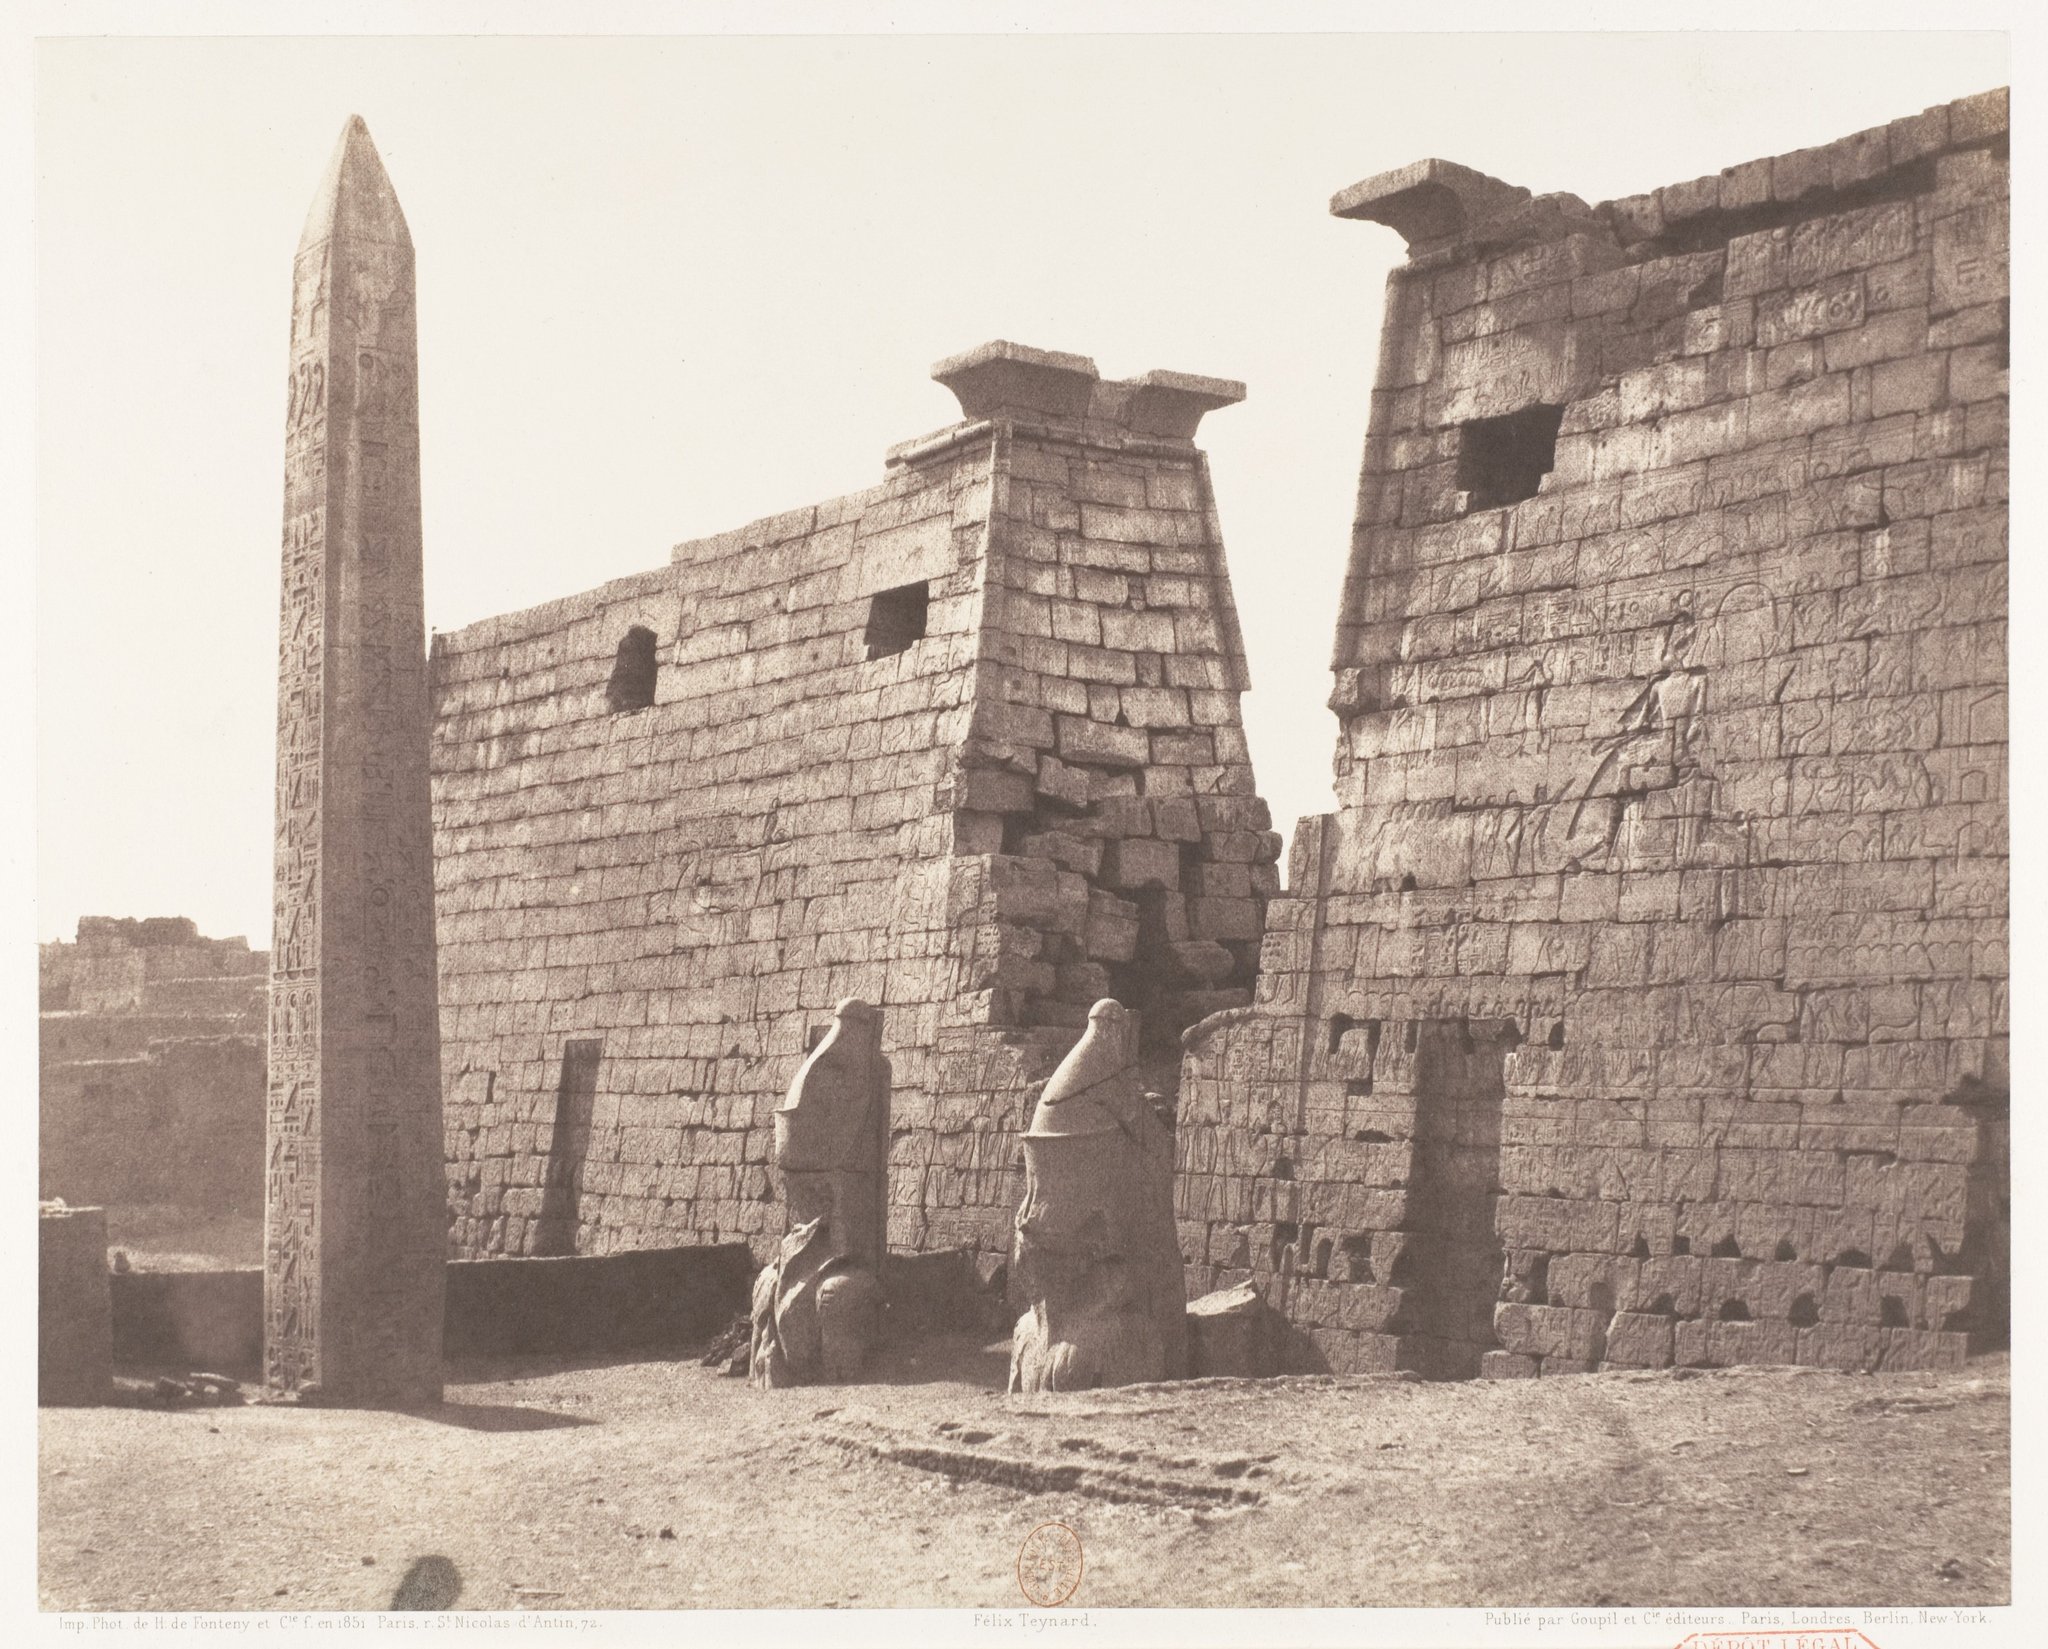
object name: photograph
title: Louksor (Thèbes), Construction Antérieure - Pylône, Colosses et Obélisque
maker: félix teynard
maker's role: artist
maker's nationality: french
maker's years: 1817-1892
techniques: paper negative, salted paper print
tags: architecture,obelisks